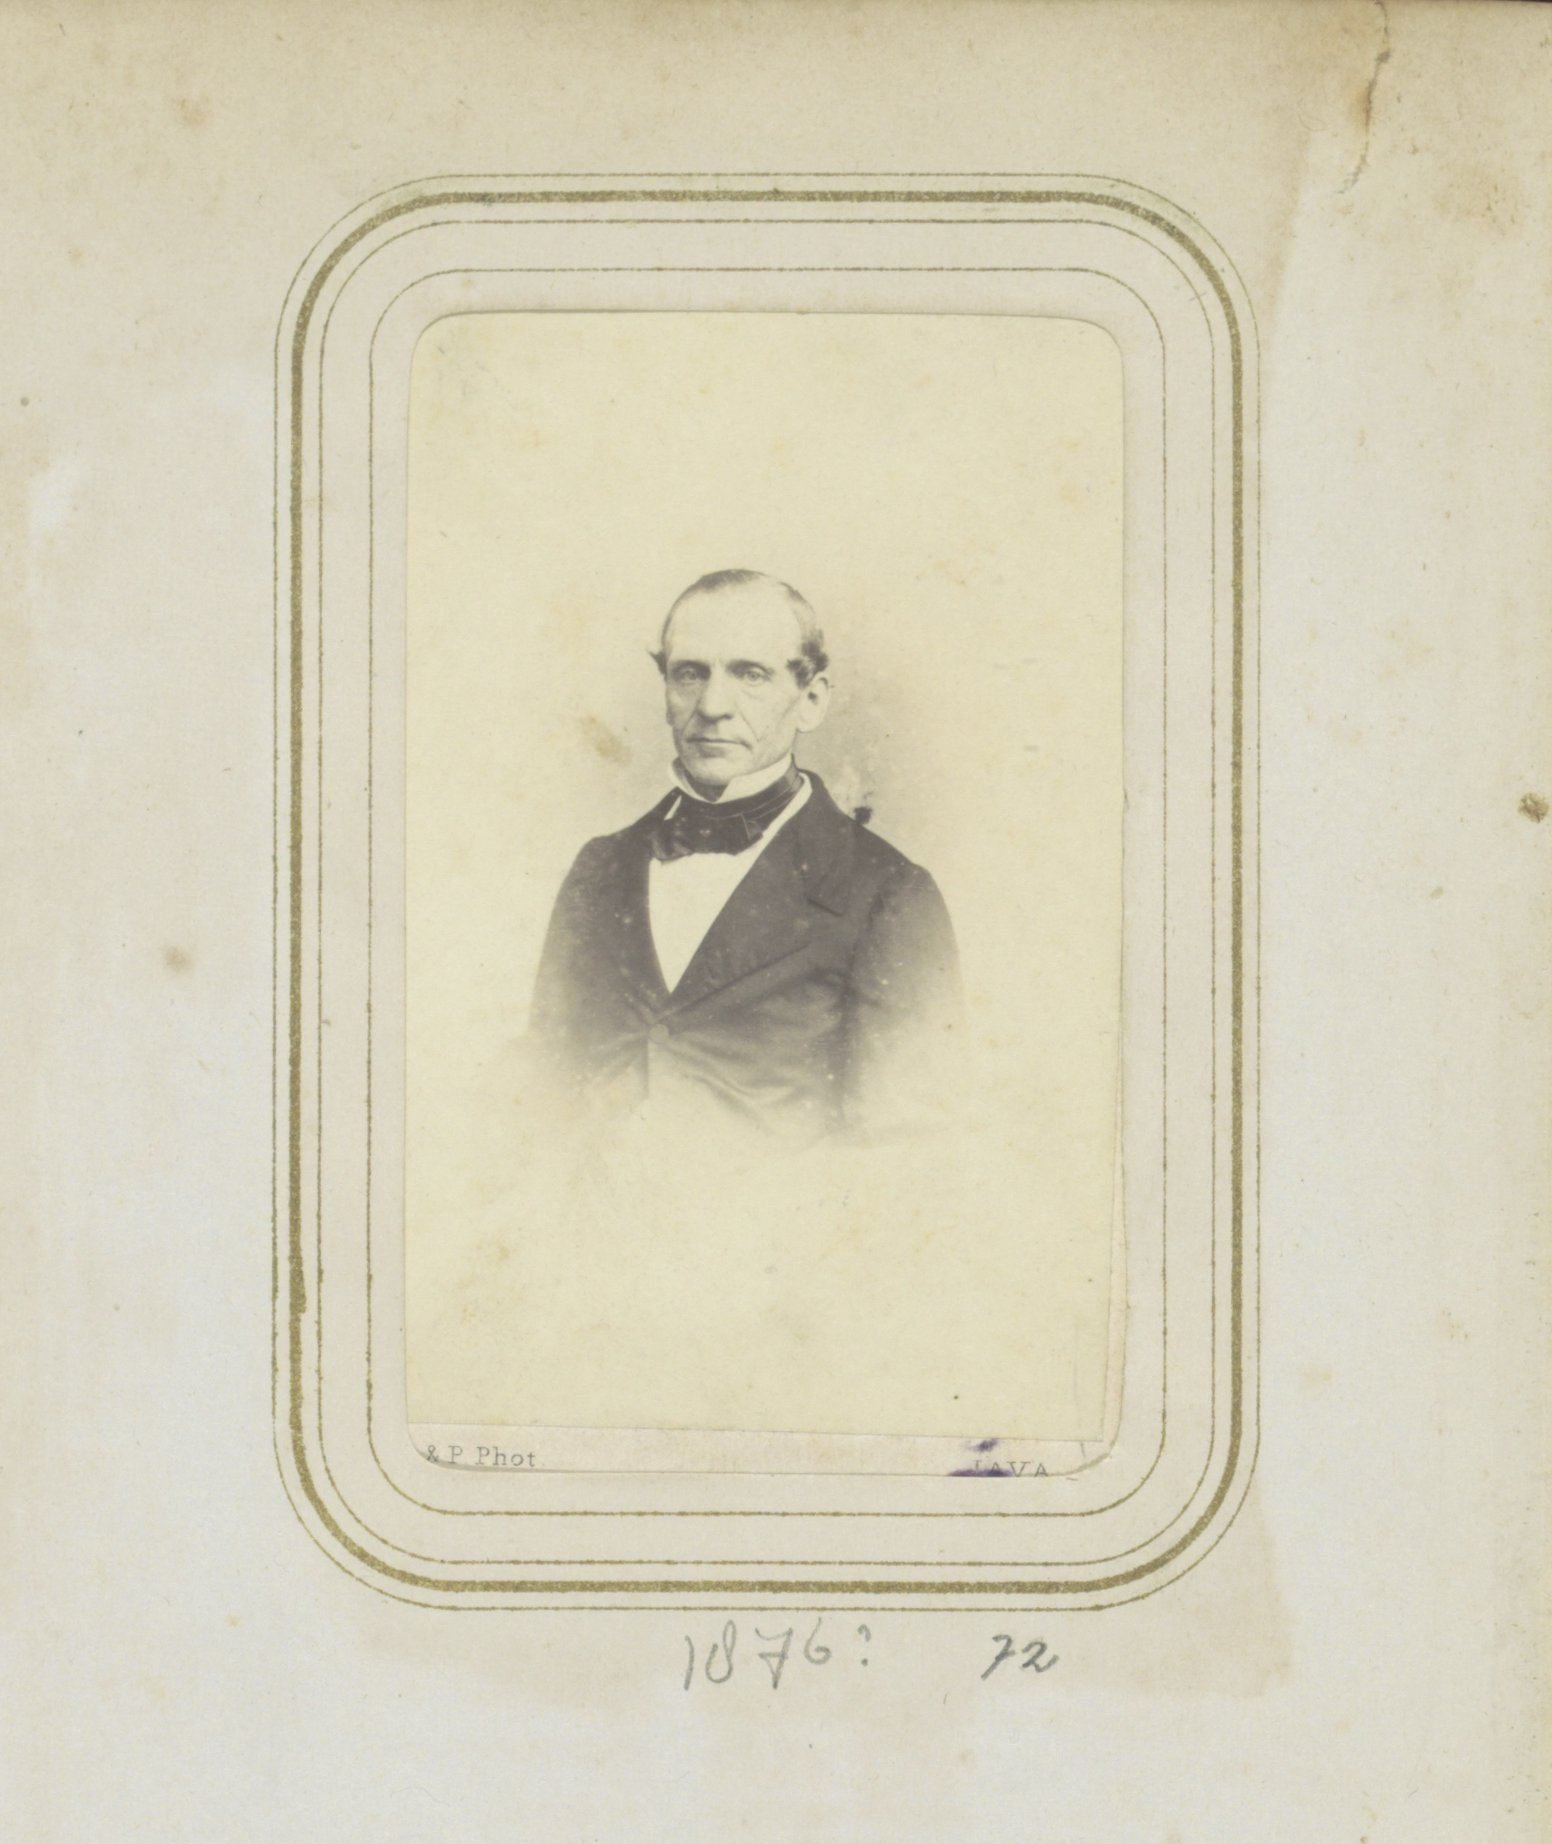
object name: carte de visite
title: Portret van een man, aangeduid als Veendra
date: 1876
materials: cardboard, photographic support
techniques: albumen print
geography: java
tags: historical persons, neck-gear ~ clothing, clothing for the upper part of the body, family, relationship, descent, hairdress, java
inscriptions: date: ‘1876?’, address: ‘Java’, inscription: ‘14/9 '96 E[...] No.[...] Veendra Ang[...]’, stamp: ‘Bo[...]andel Wed.[...] nd van Eck P[...]t, 128 [...]ag.’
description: Onderdeel van Familiealbum van H.W.F. Ligtenberg en L.M. Swart met 149 foto's en cartes-de-visite.